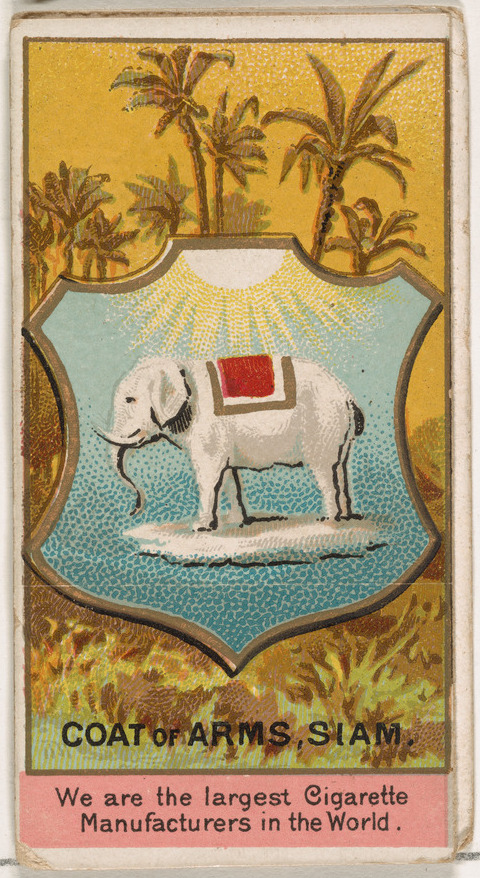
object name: print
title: An Idol of Siam, from the Rulers, Flags, and Coats of Arms series (N126-2) issued by W. Duke, Sons & Co.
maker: w. duke, sons & co.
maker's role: publisher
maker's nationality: american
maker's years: 1870-1920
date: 1888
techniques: color lithograph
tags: coat of arms